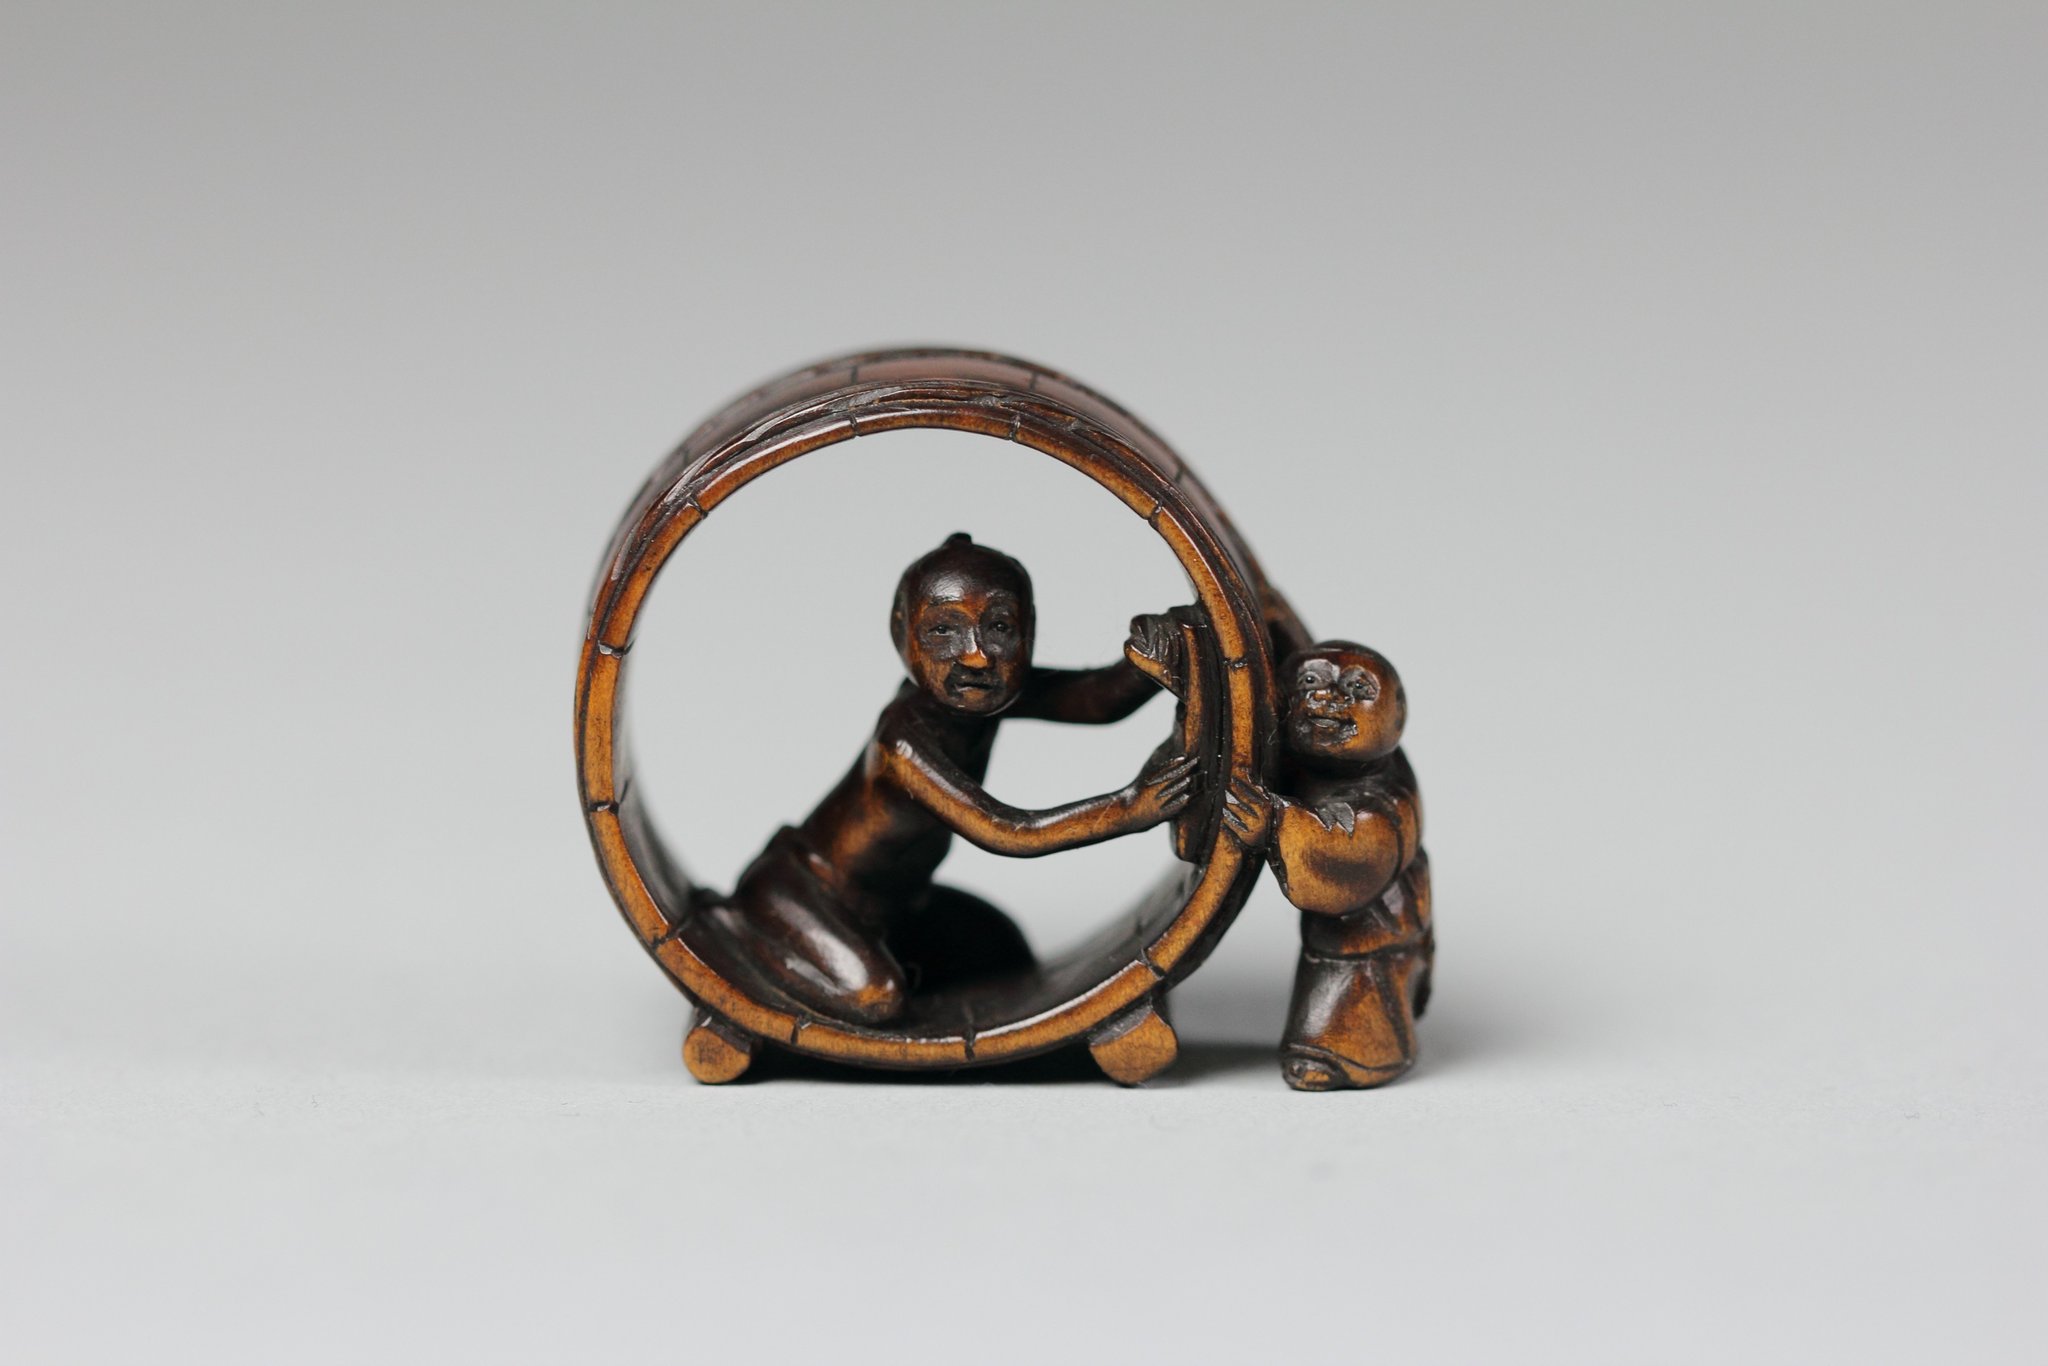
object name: netsuke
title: Netsuke of Two Figures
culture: japanese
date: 1801-1900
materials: wood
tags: men